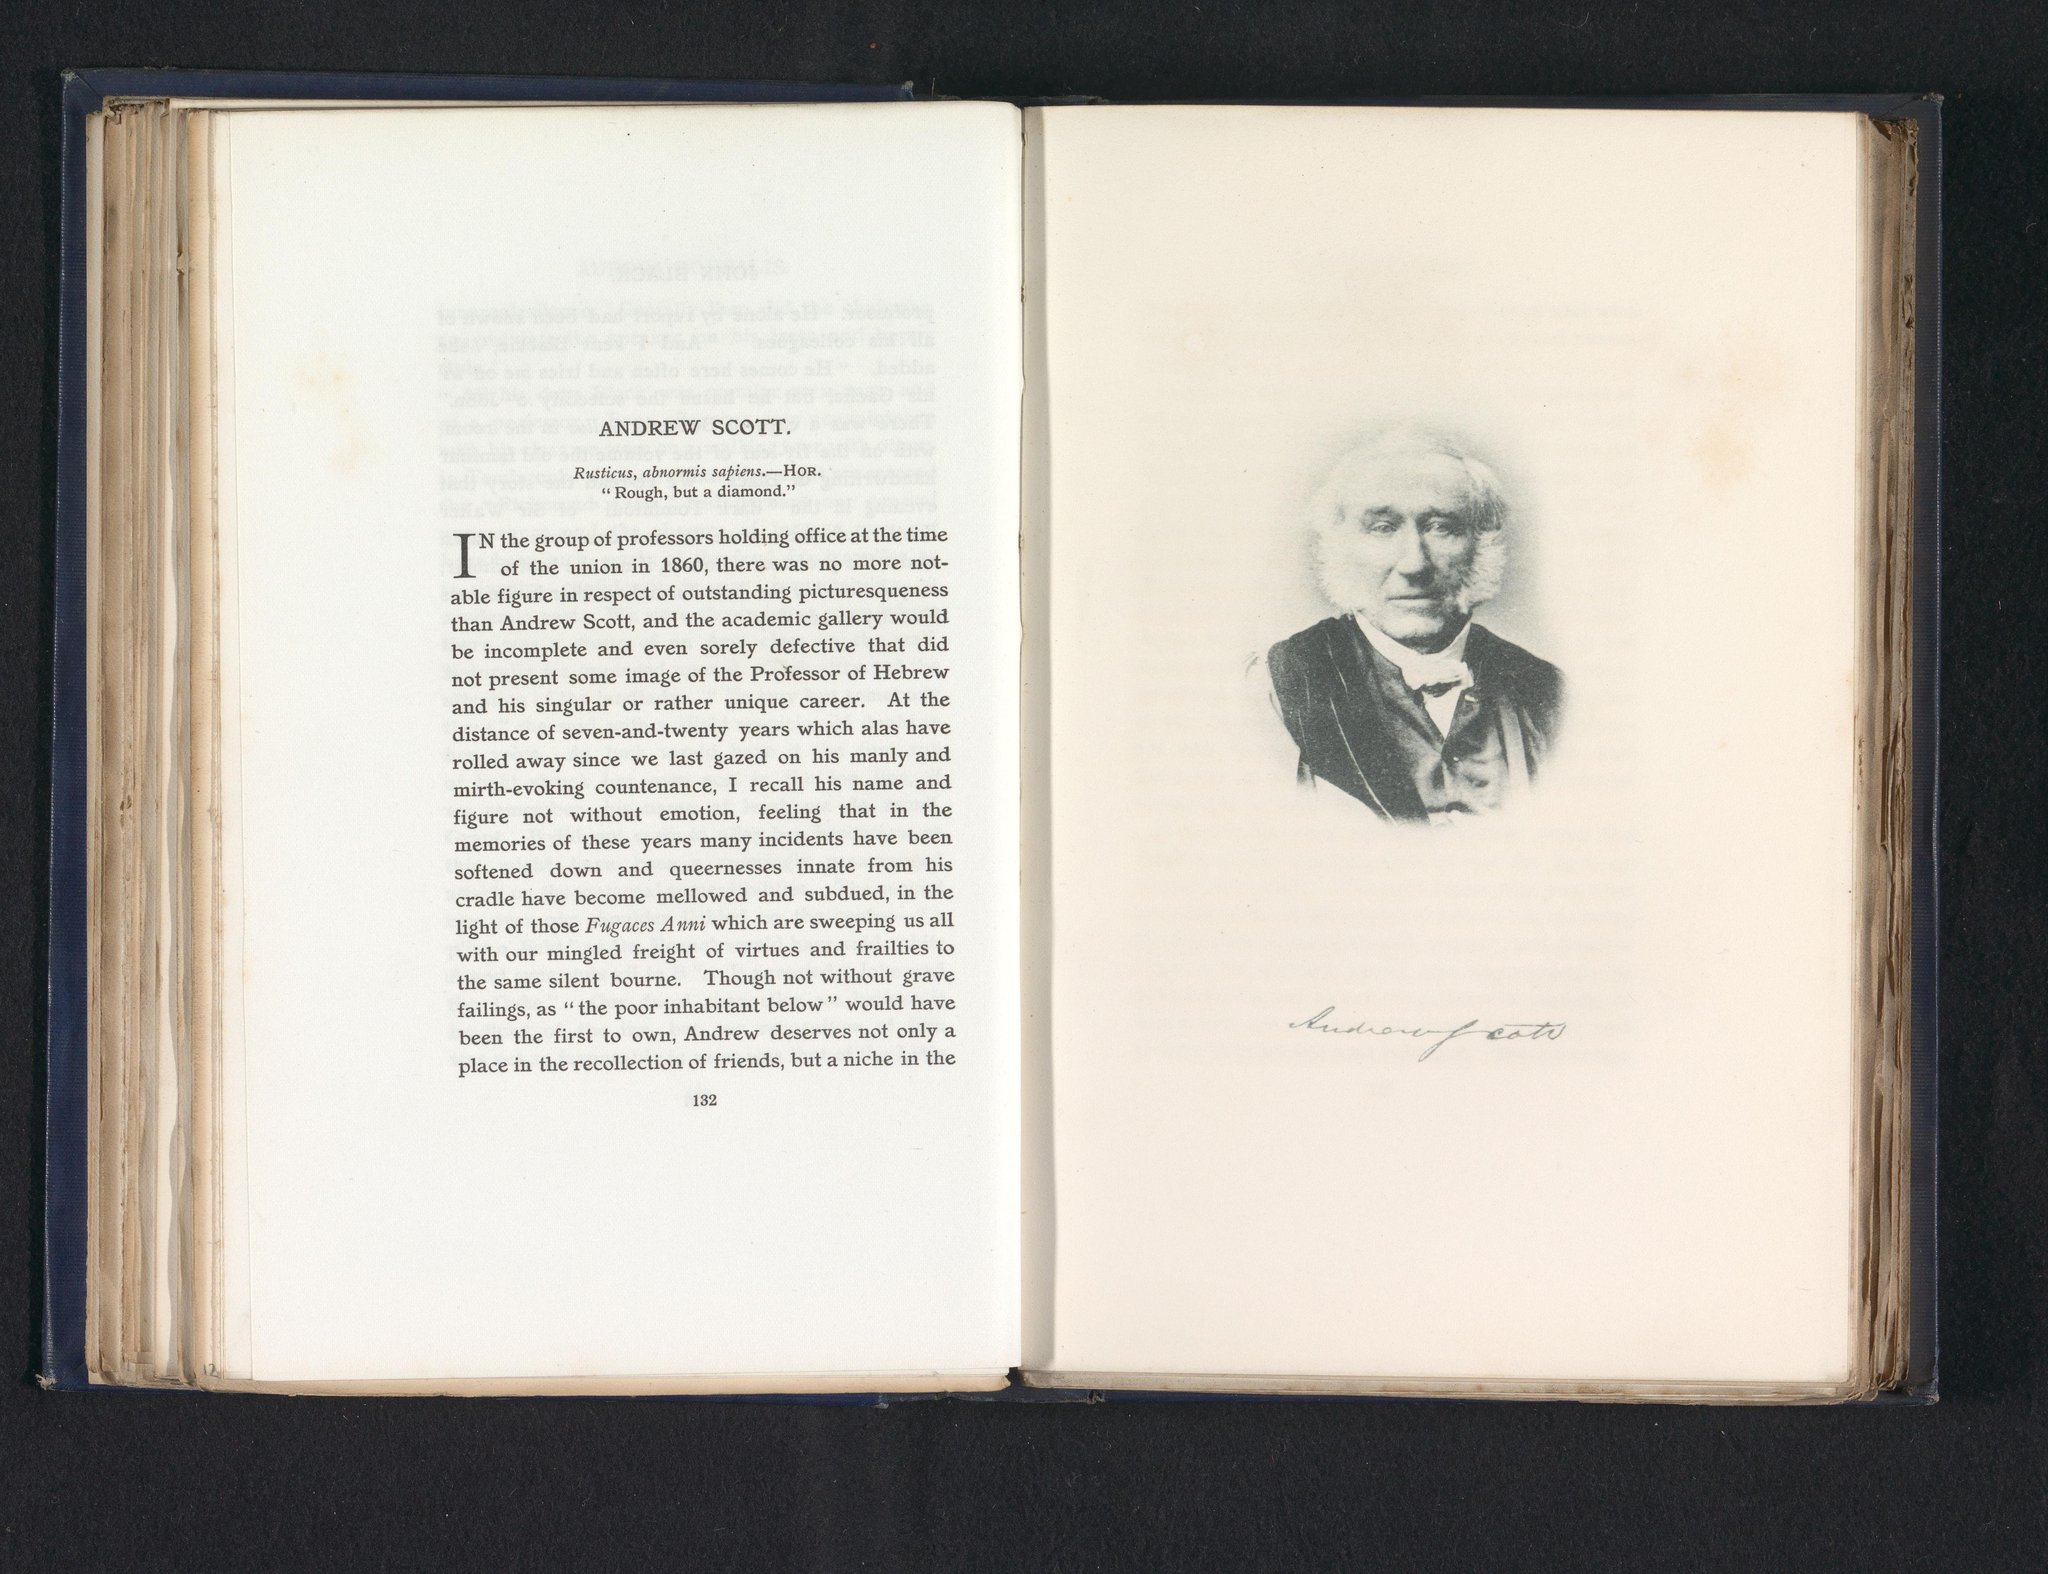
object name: page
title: Portret van Andrew Scott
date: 1889-1899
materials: paper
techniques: photograph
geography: aberdeen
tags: scholar, philosopher